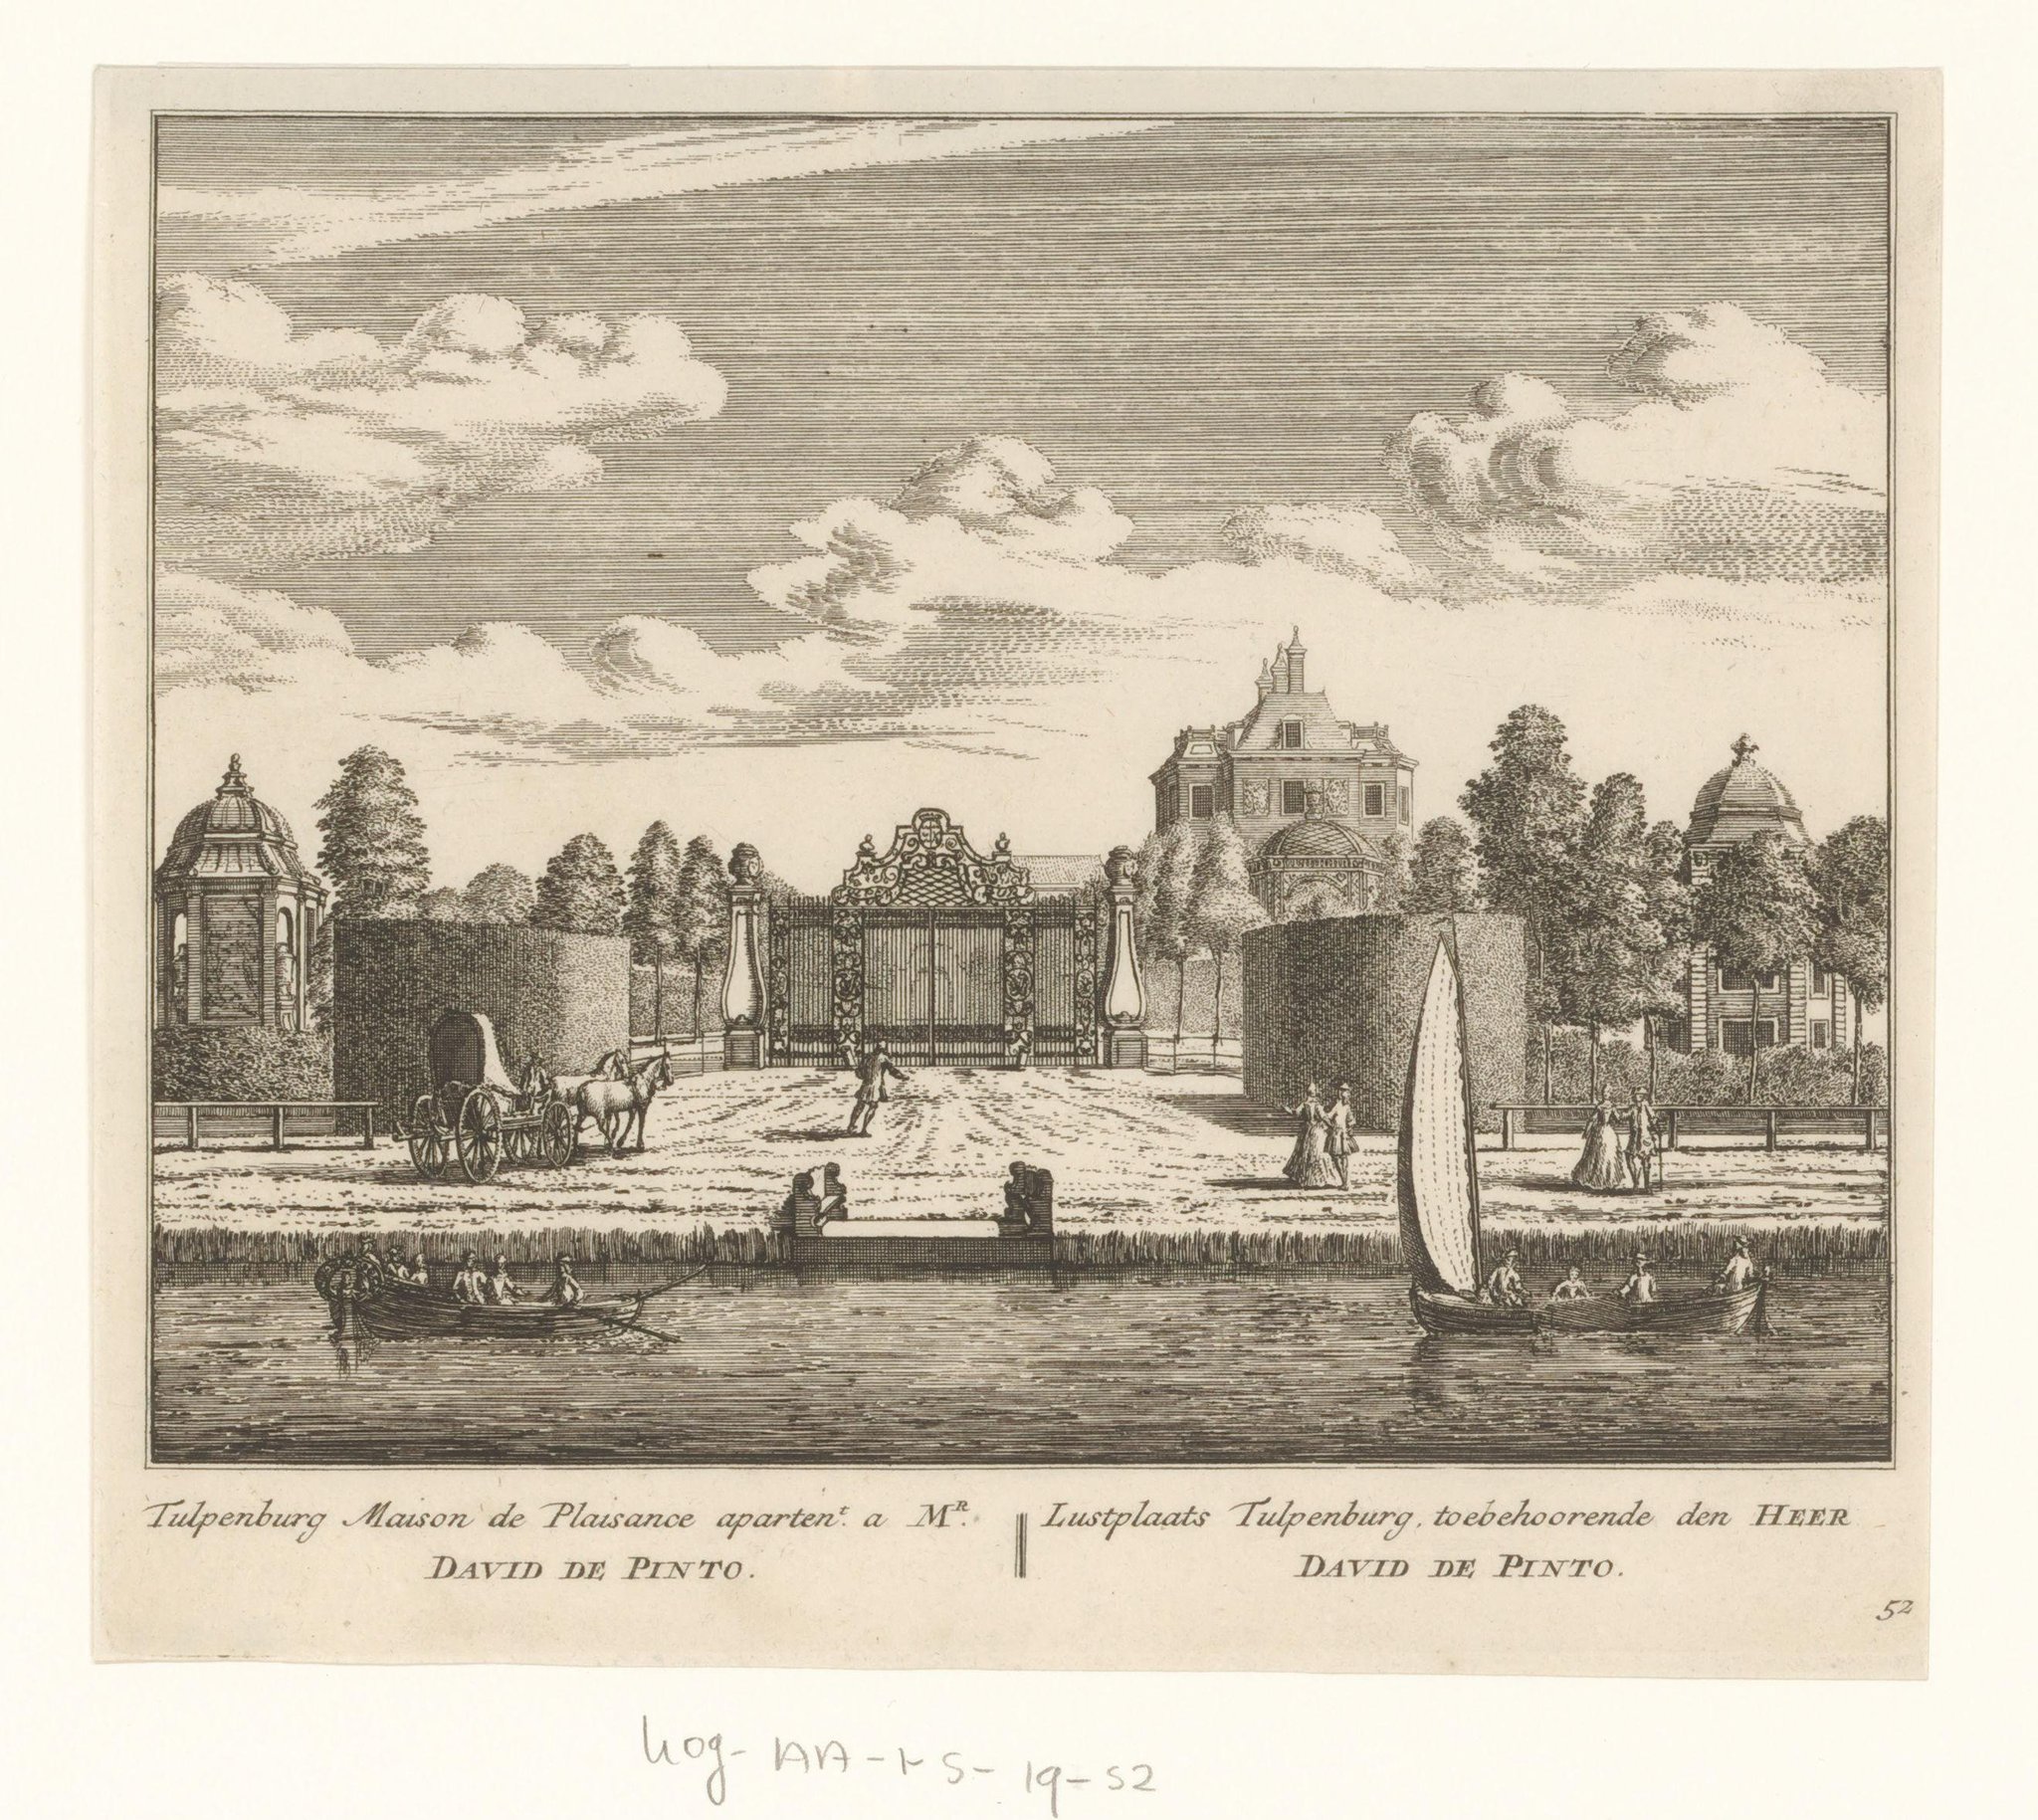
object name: print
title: Hollands Arcadia, of de vermaarde rivier den Amstel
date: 1730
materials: paper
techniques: etching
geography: amsterdam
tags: sailing-ship, sailing-boat, city-view in general; 'veduta', river, rural housing, e.g. country-house, villa, cottage, gate, entrance, boat propelled by man or animal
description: Prent waarschijnlijk uit: Tijsens, Gijsbert. Hollands Arcadia, of de vermaarde rivier den Amstel (...) naar 't léven getekend en in 't ligt gebragt door Abraham Rademaker (...). Amsterdam: Leonardus Schenk, 1730.